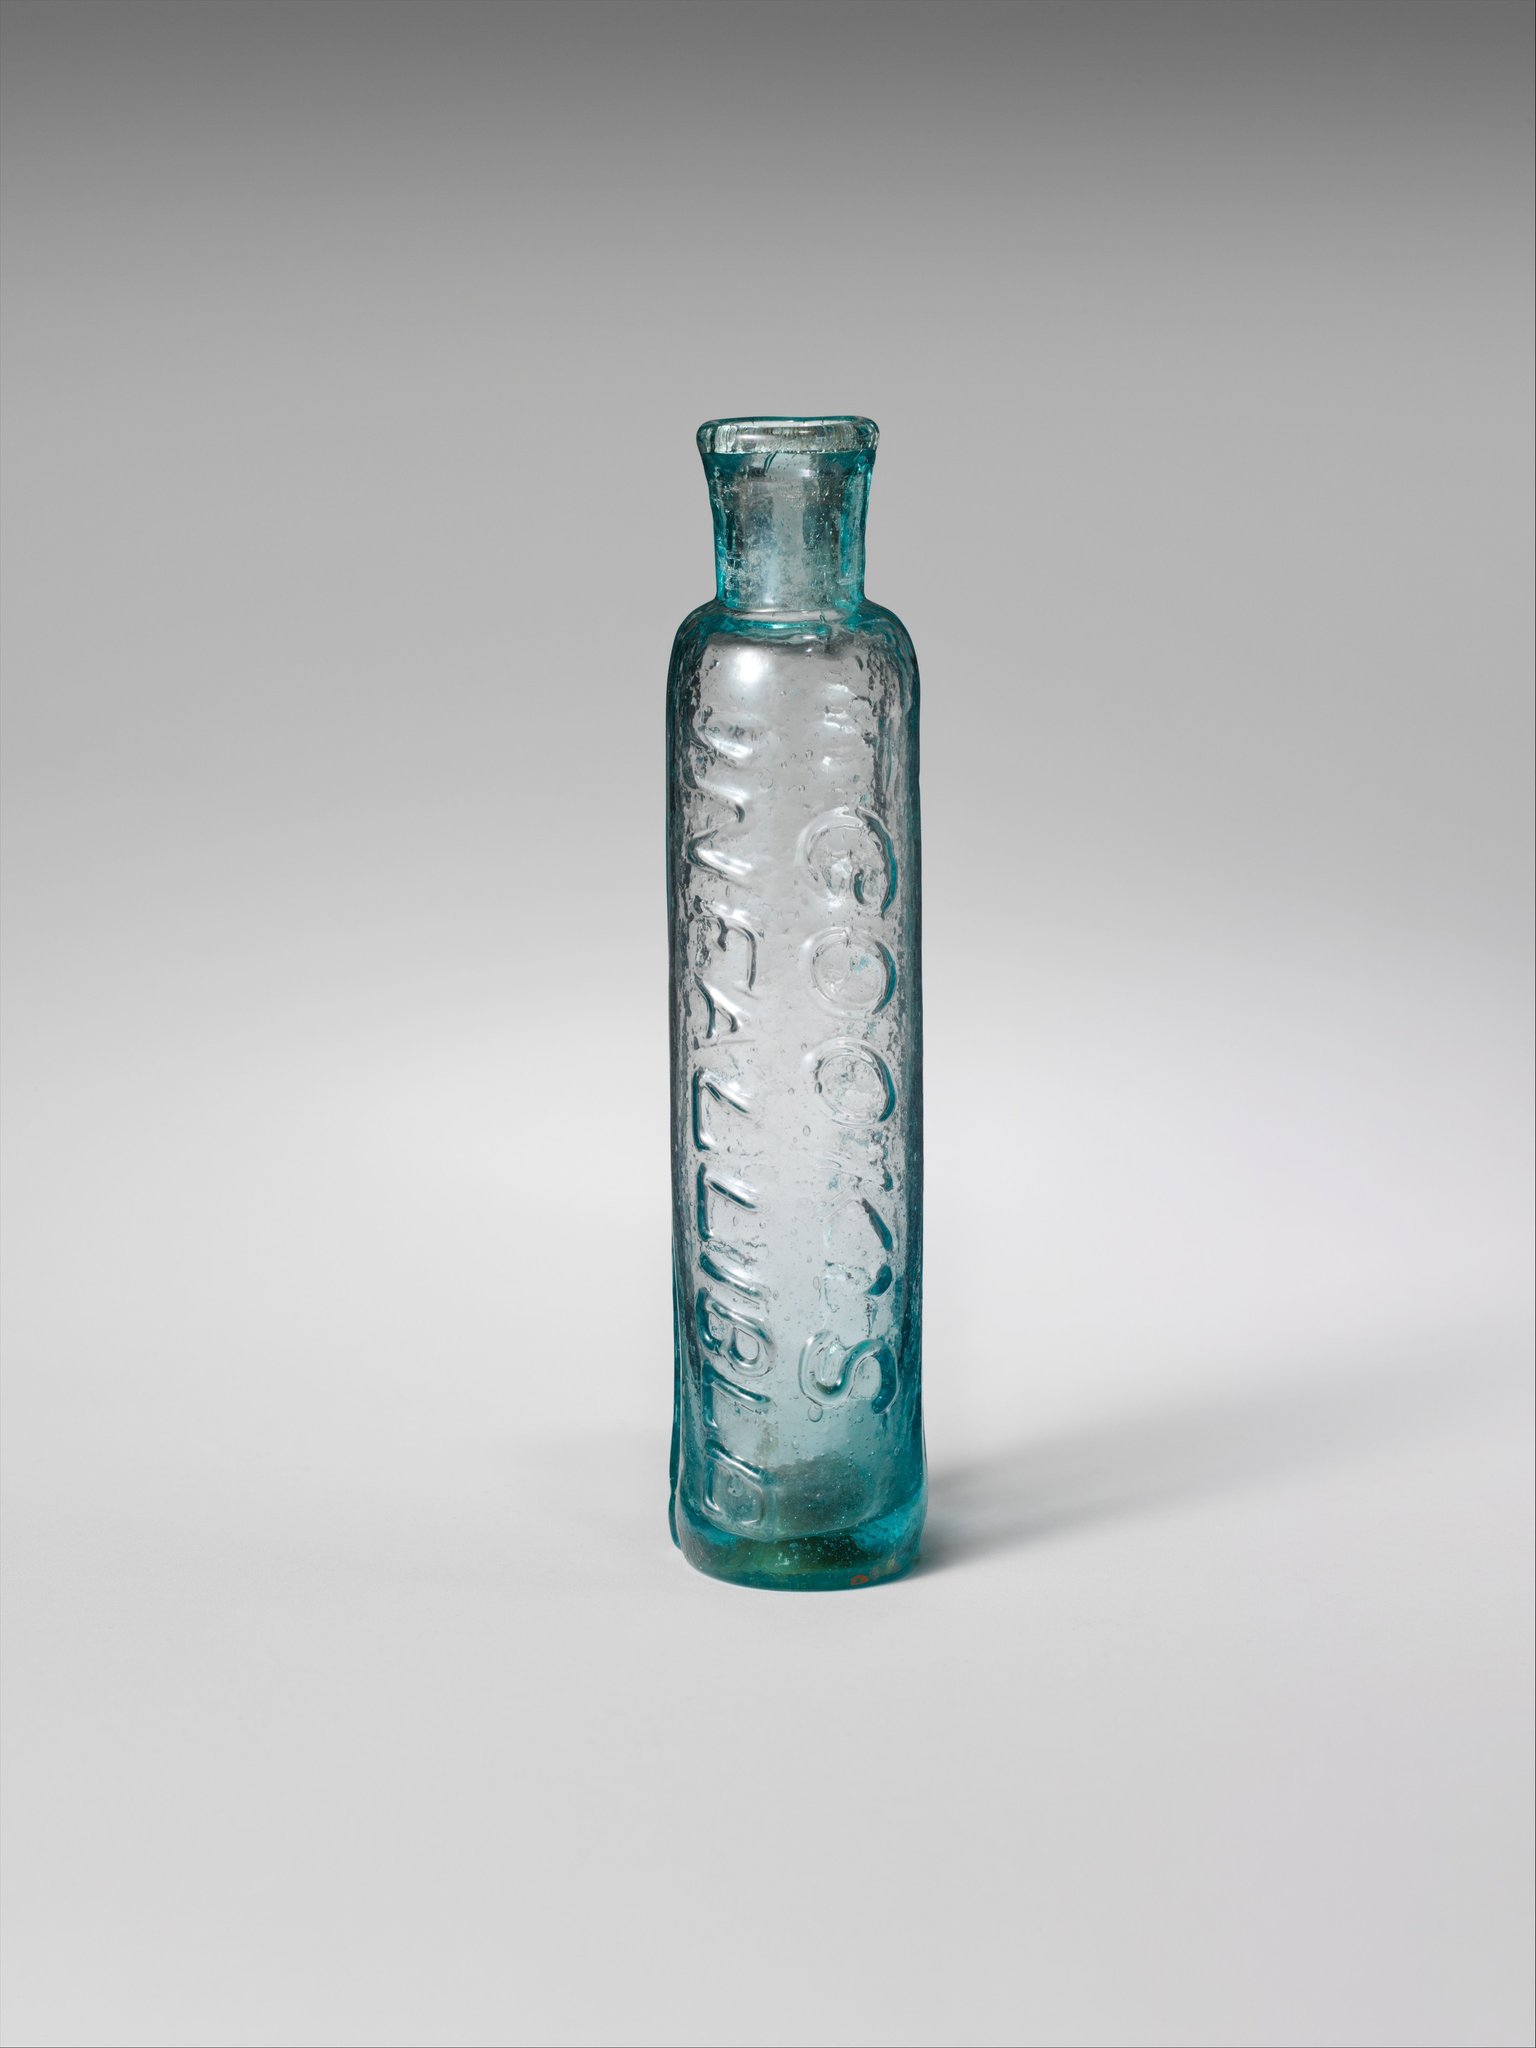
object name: bottle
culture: american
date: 1700-1800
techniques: glassblowing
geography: united states